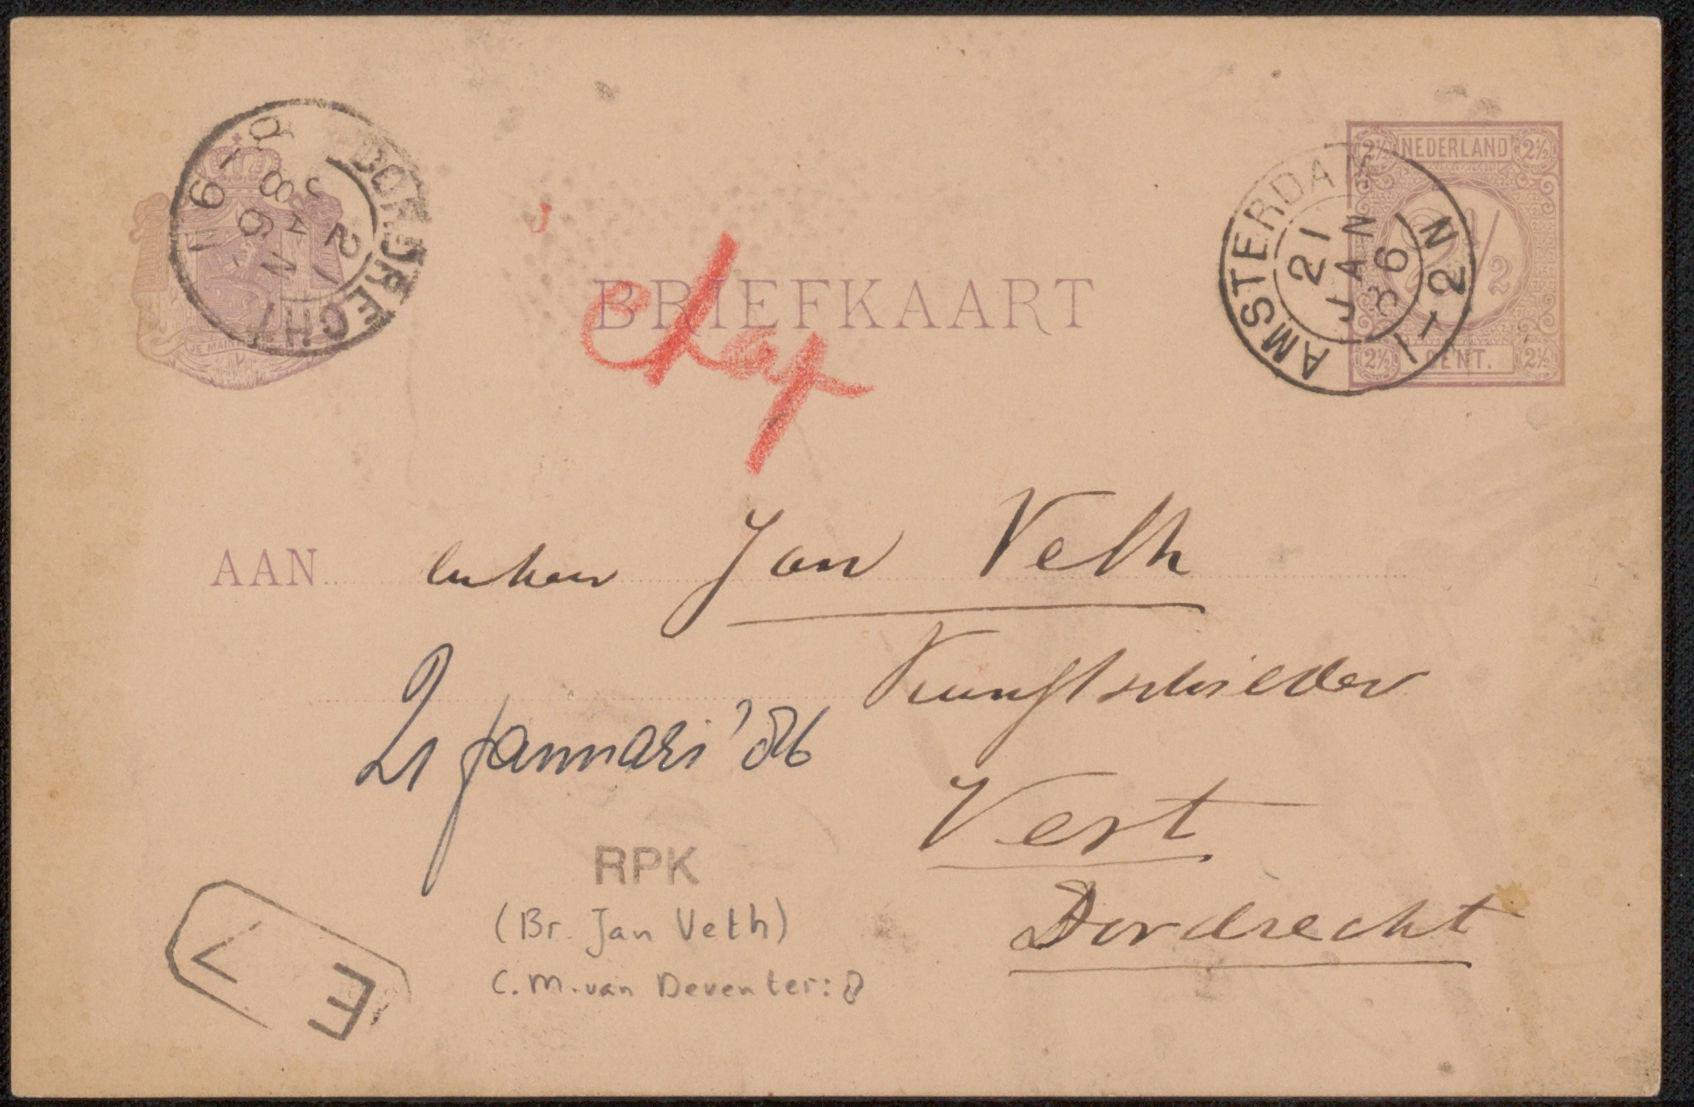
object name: postcard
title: Briefkaart aan Jan Veth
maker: chap van deventer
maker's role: kunstcriticus, scheikundige, schrijver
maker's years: 1860-1931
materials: cardboard, ink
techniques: pen, writing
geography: amsterdam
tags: painter, print maker, draughtsman, designer, jan veth, literature ~ arts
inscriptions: collector's mark: ‘RPK’